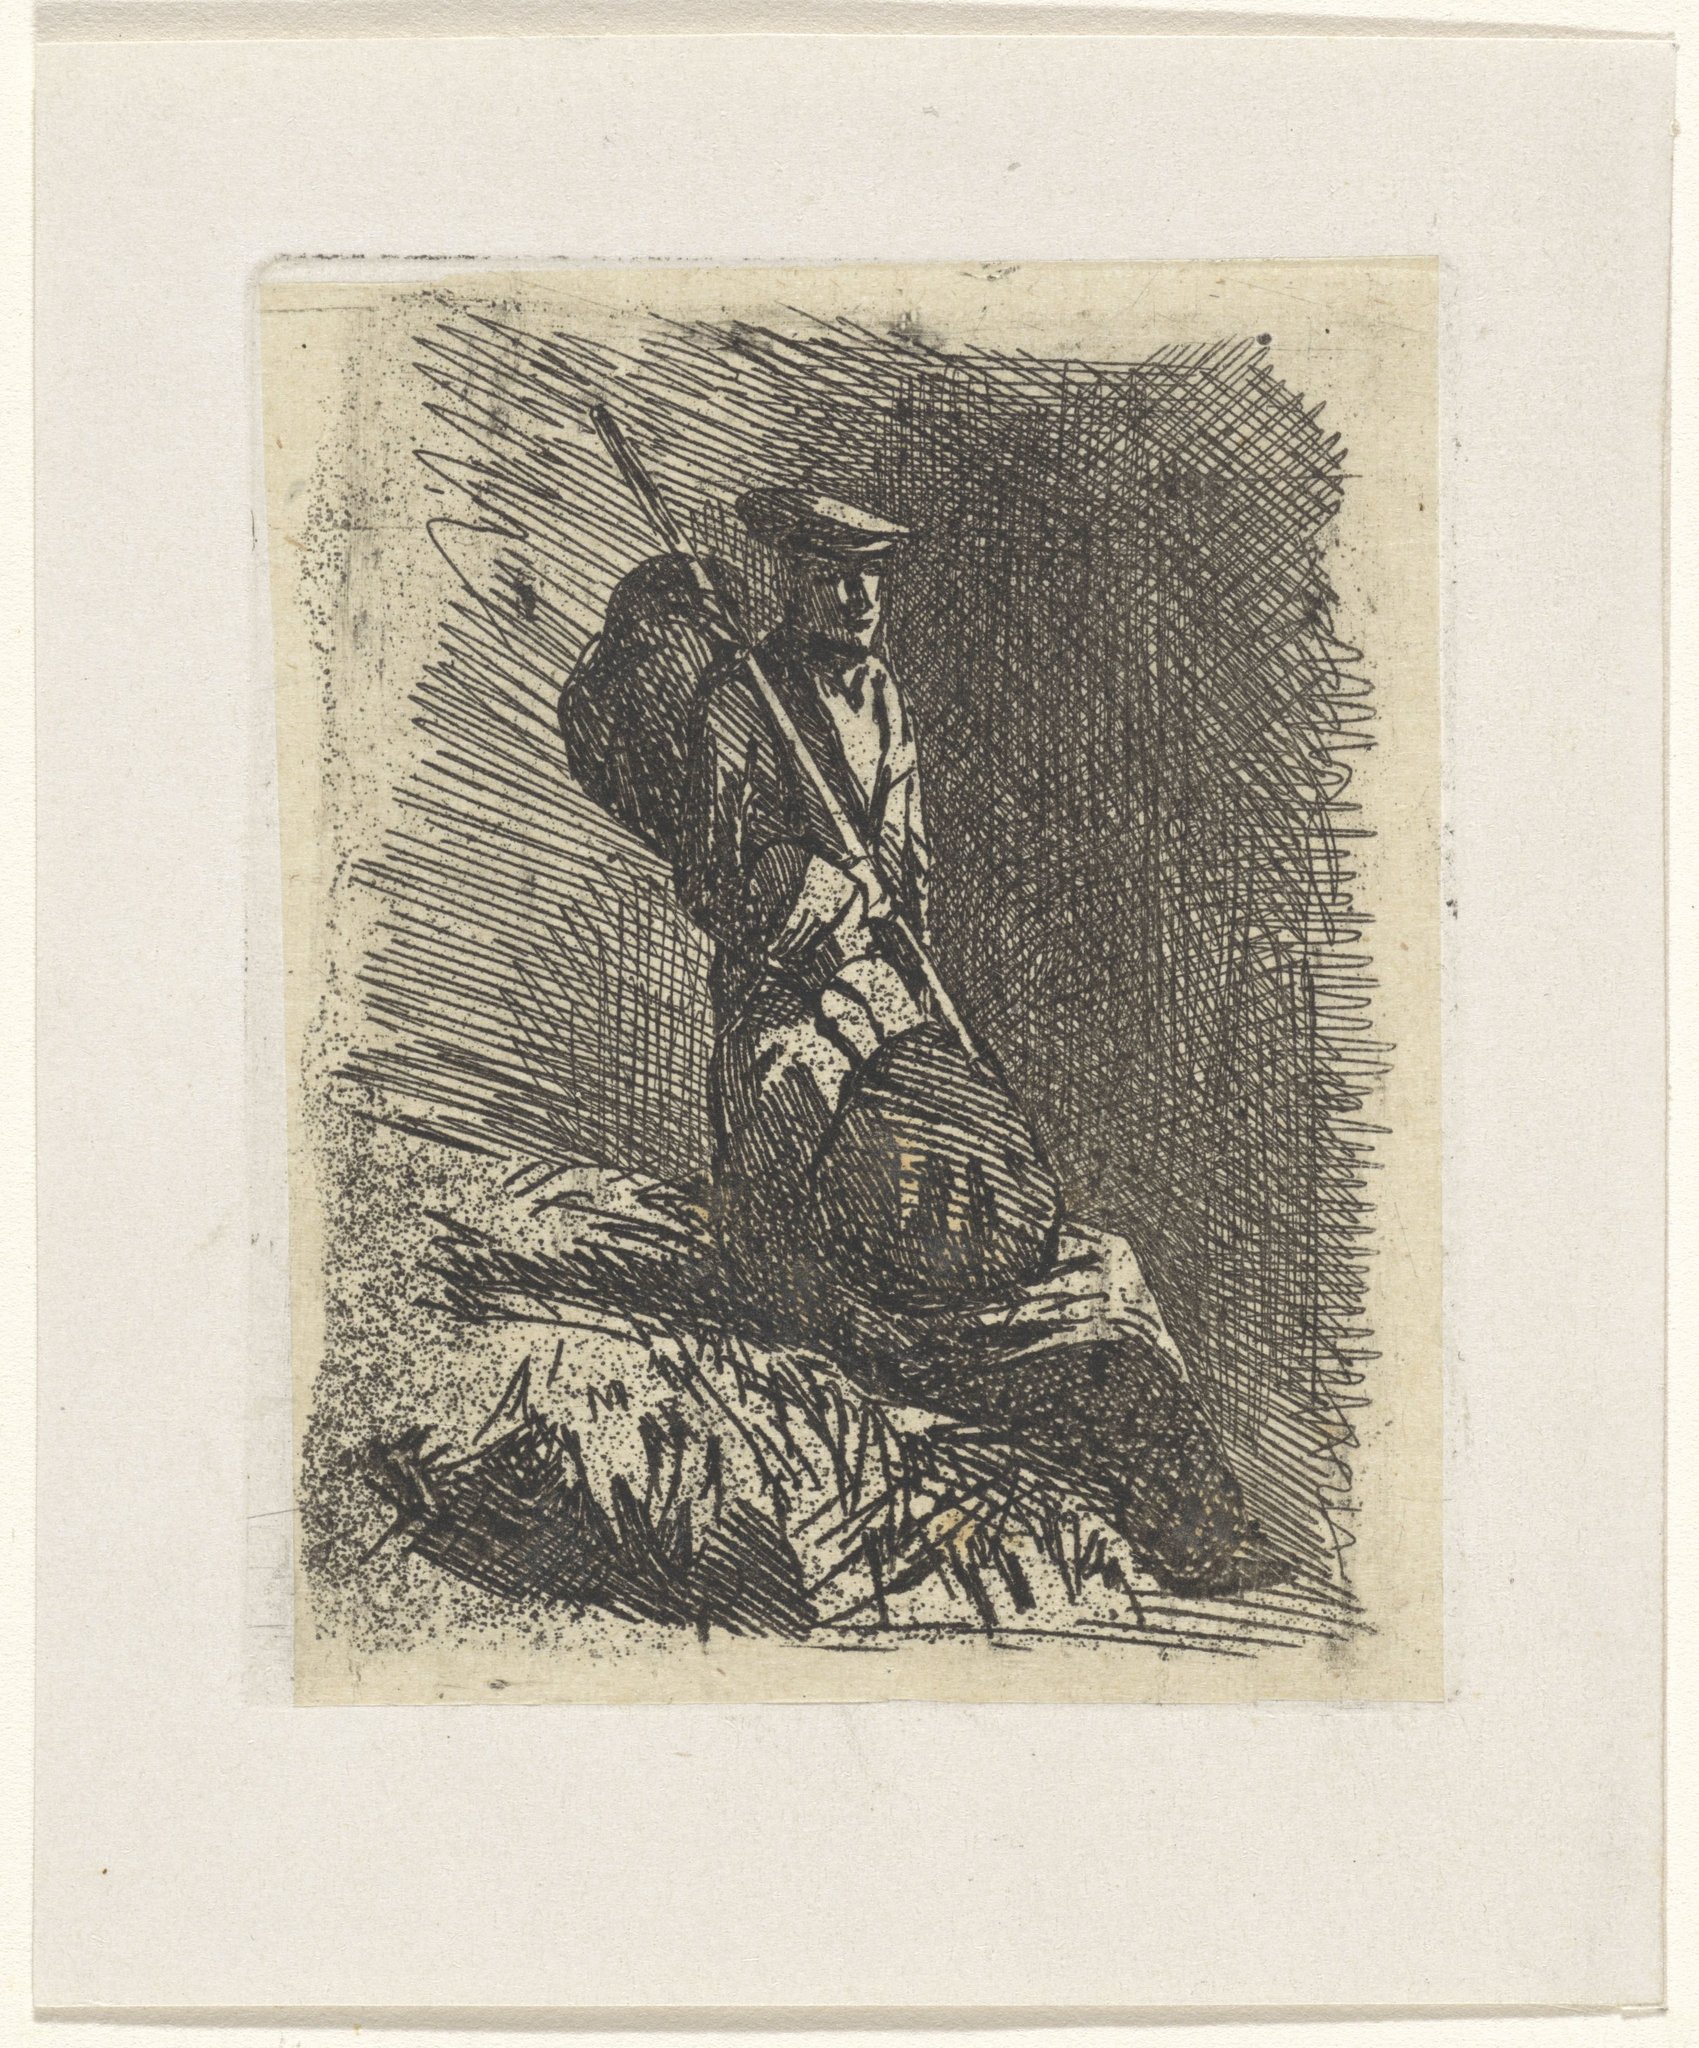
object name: print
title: Arme man en vrouw met kind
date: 1837-1887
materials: paper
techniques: etching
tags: bag, child, children (first degree family relationships), parents (first degree family relationships)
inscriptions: collector's mark: Lugt 2228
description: Op de grond zit een vrouw met een klein kind op haar schoot. Bij haar staat een man met een stok en een tas op zijn rug.